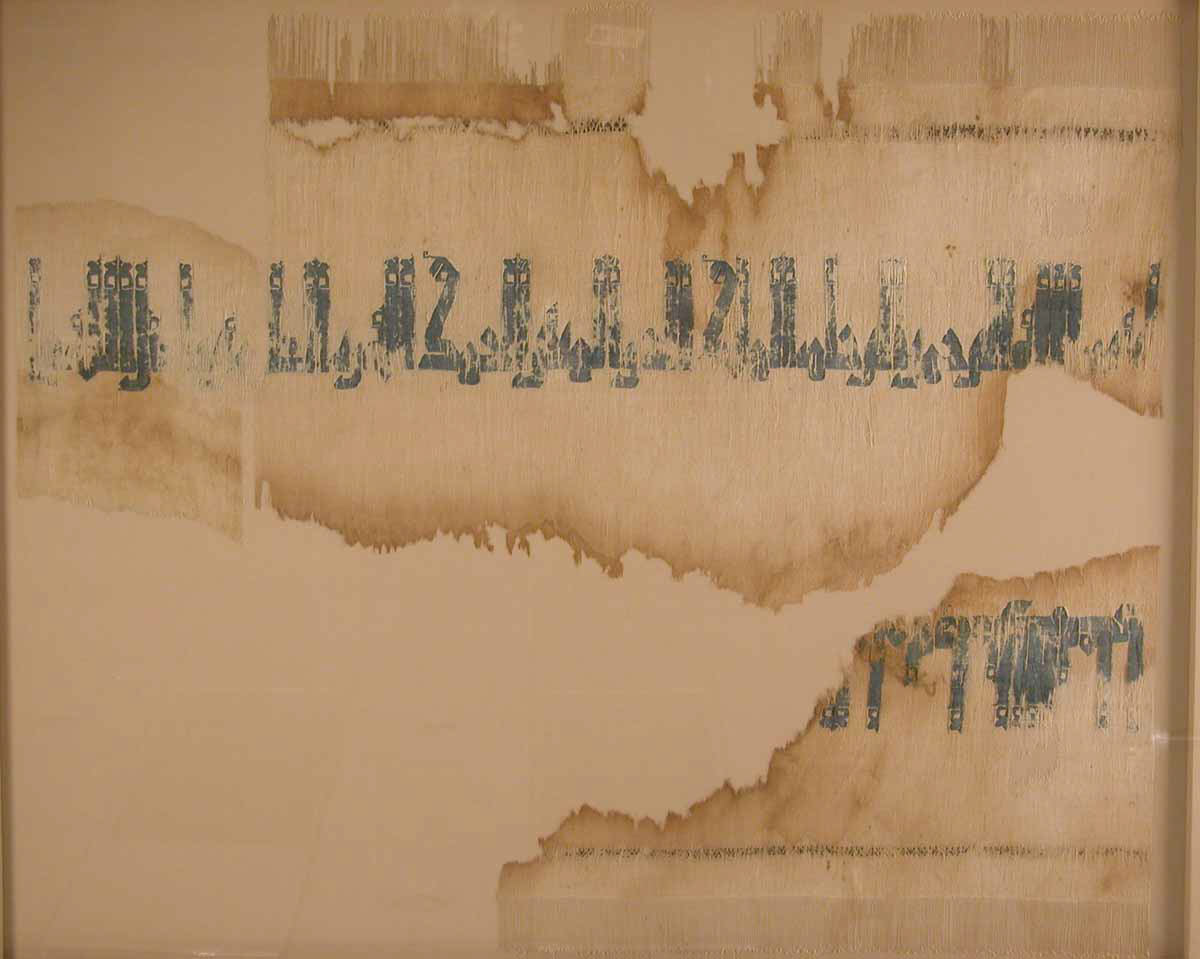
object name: tiraz fragment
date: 901-1000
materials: linen, silk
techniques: weave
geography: egypt